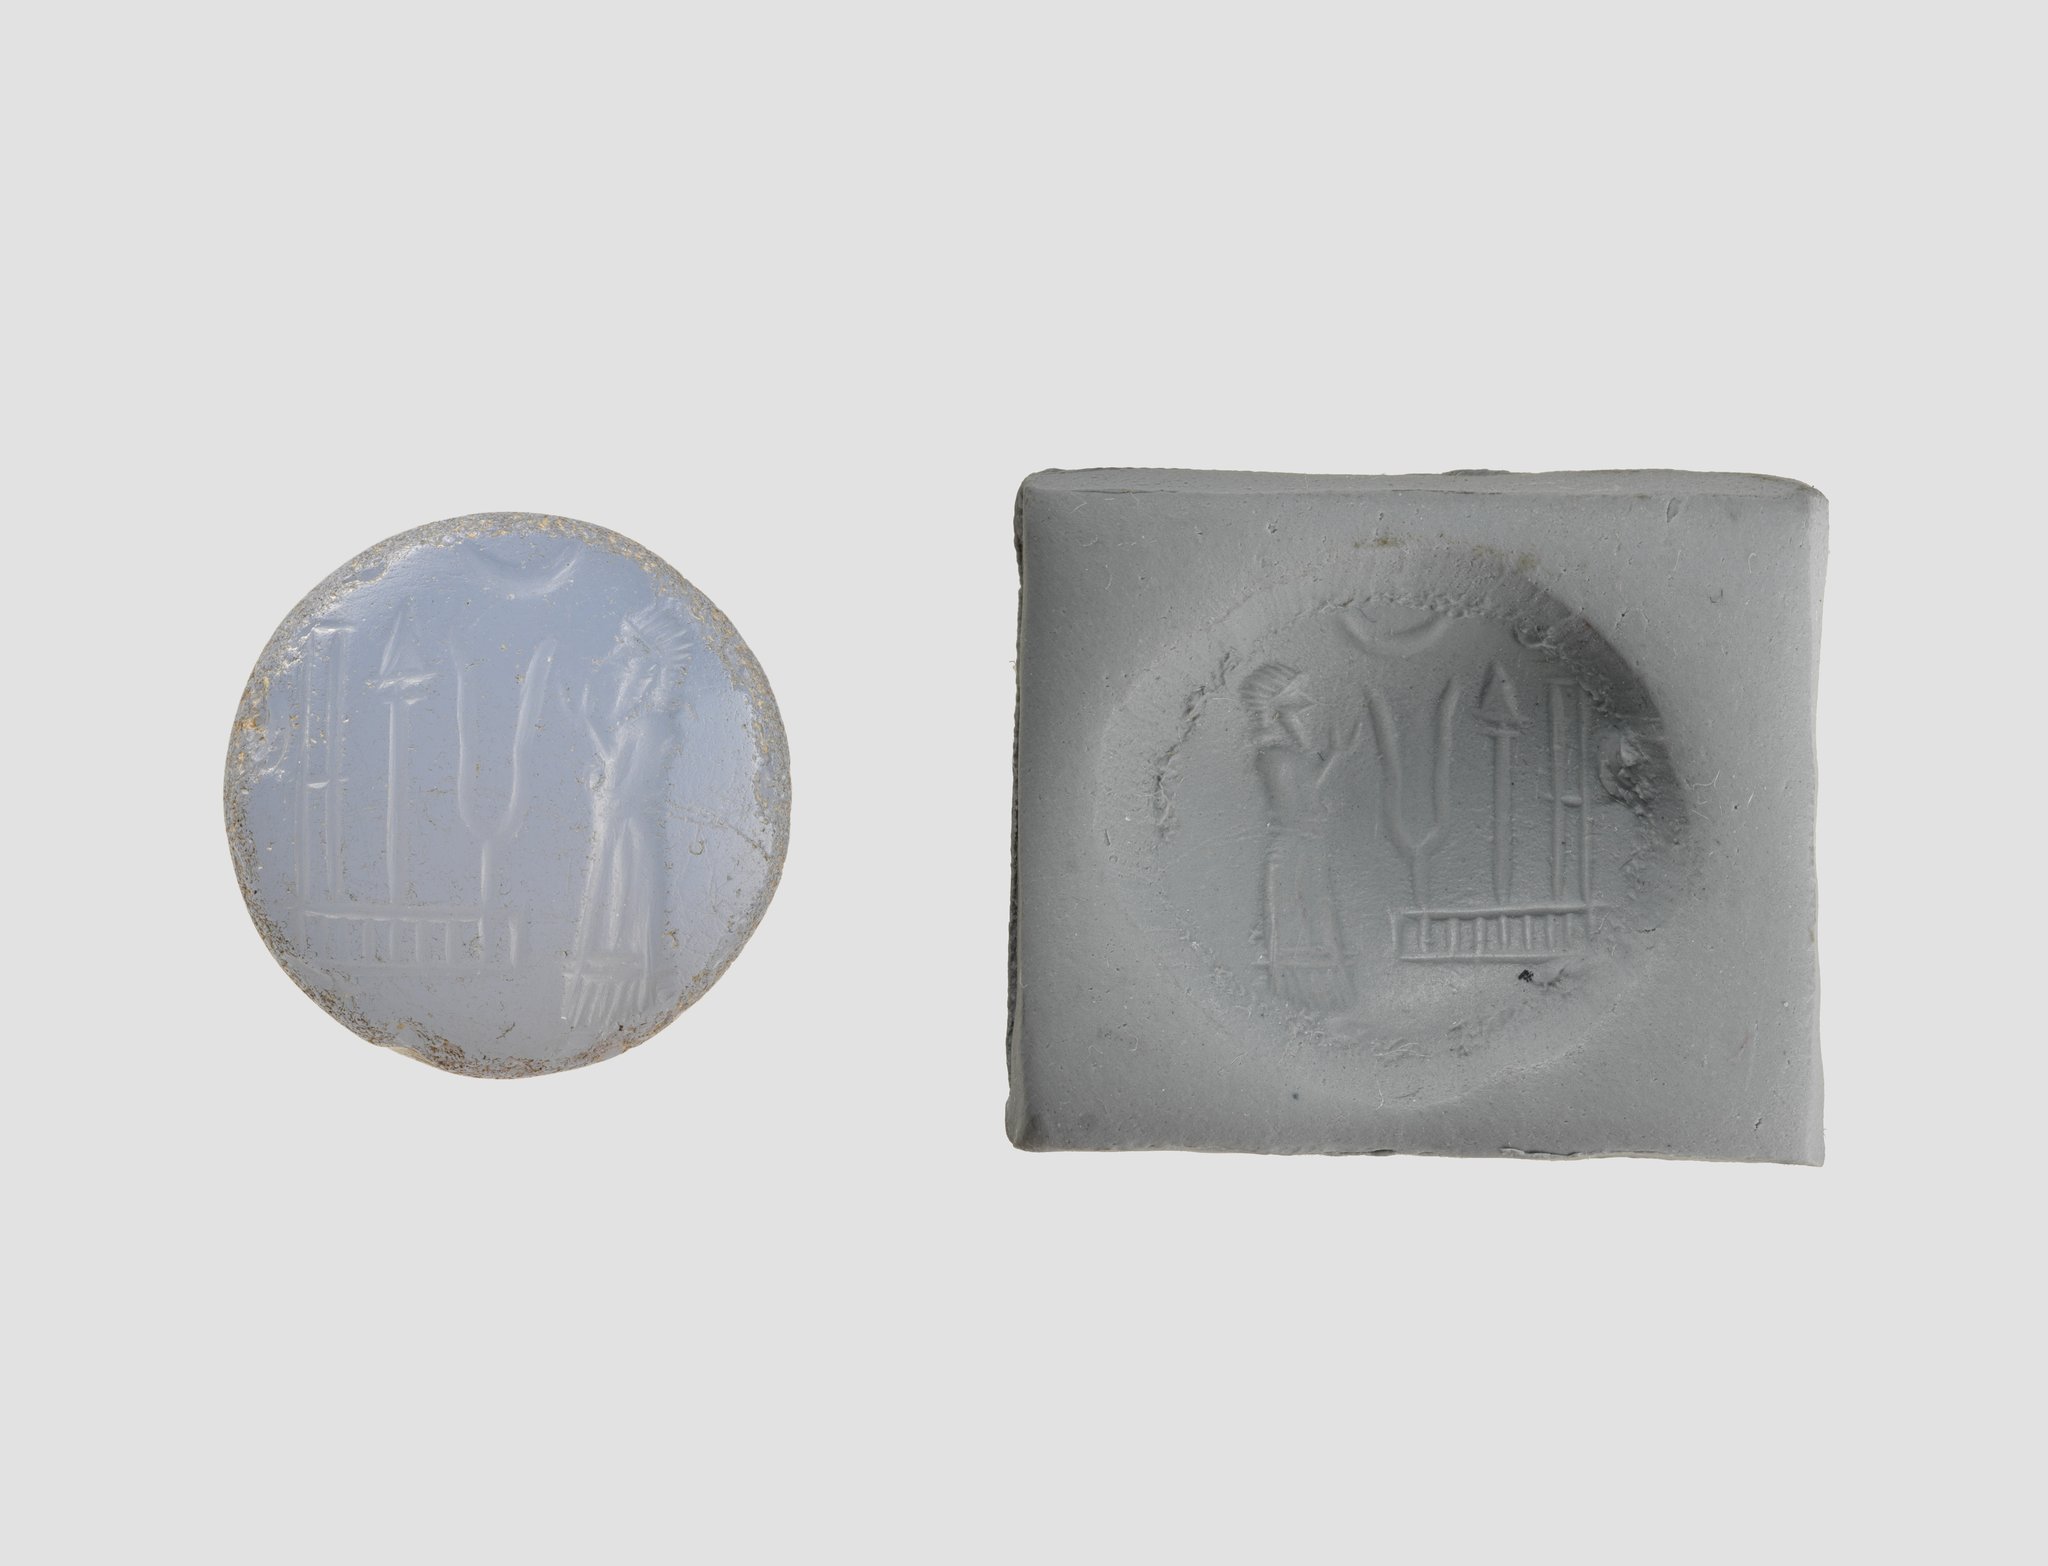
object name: stamp seal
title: Stamp seal (conoid) with cultic scene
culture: assyro-babylonian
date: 734-501 BCE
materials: stone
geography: mesopotamia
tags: men